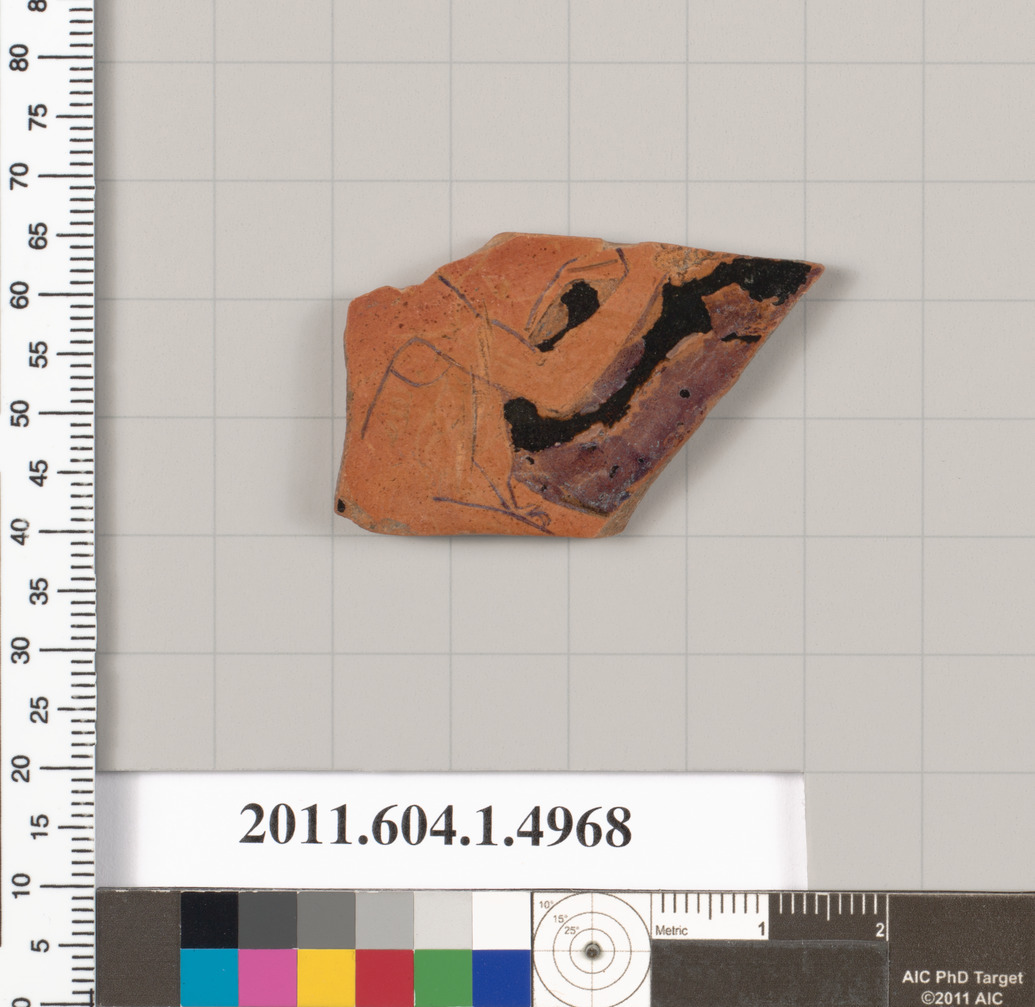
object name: kylix fragment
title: Terracotta fragment of a kylix (drinking cup)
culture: greek, attic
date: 500-480 BCE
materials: terracotta